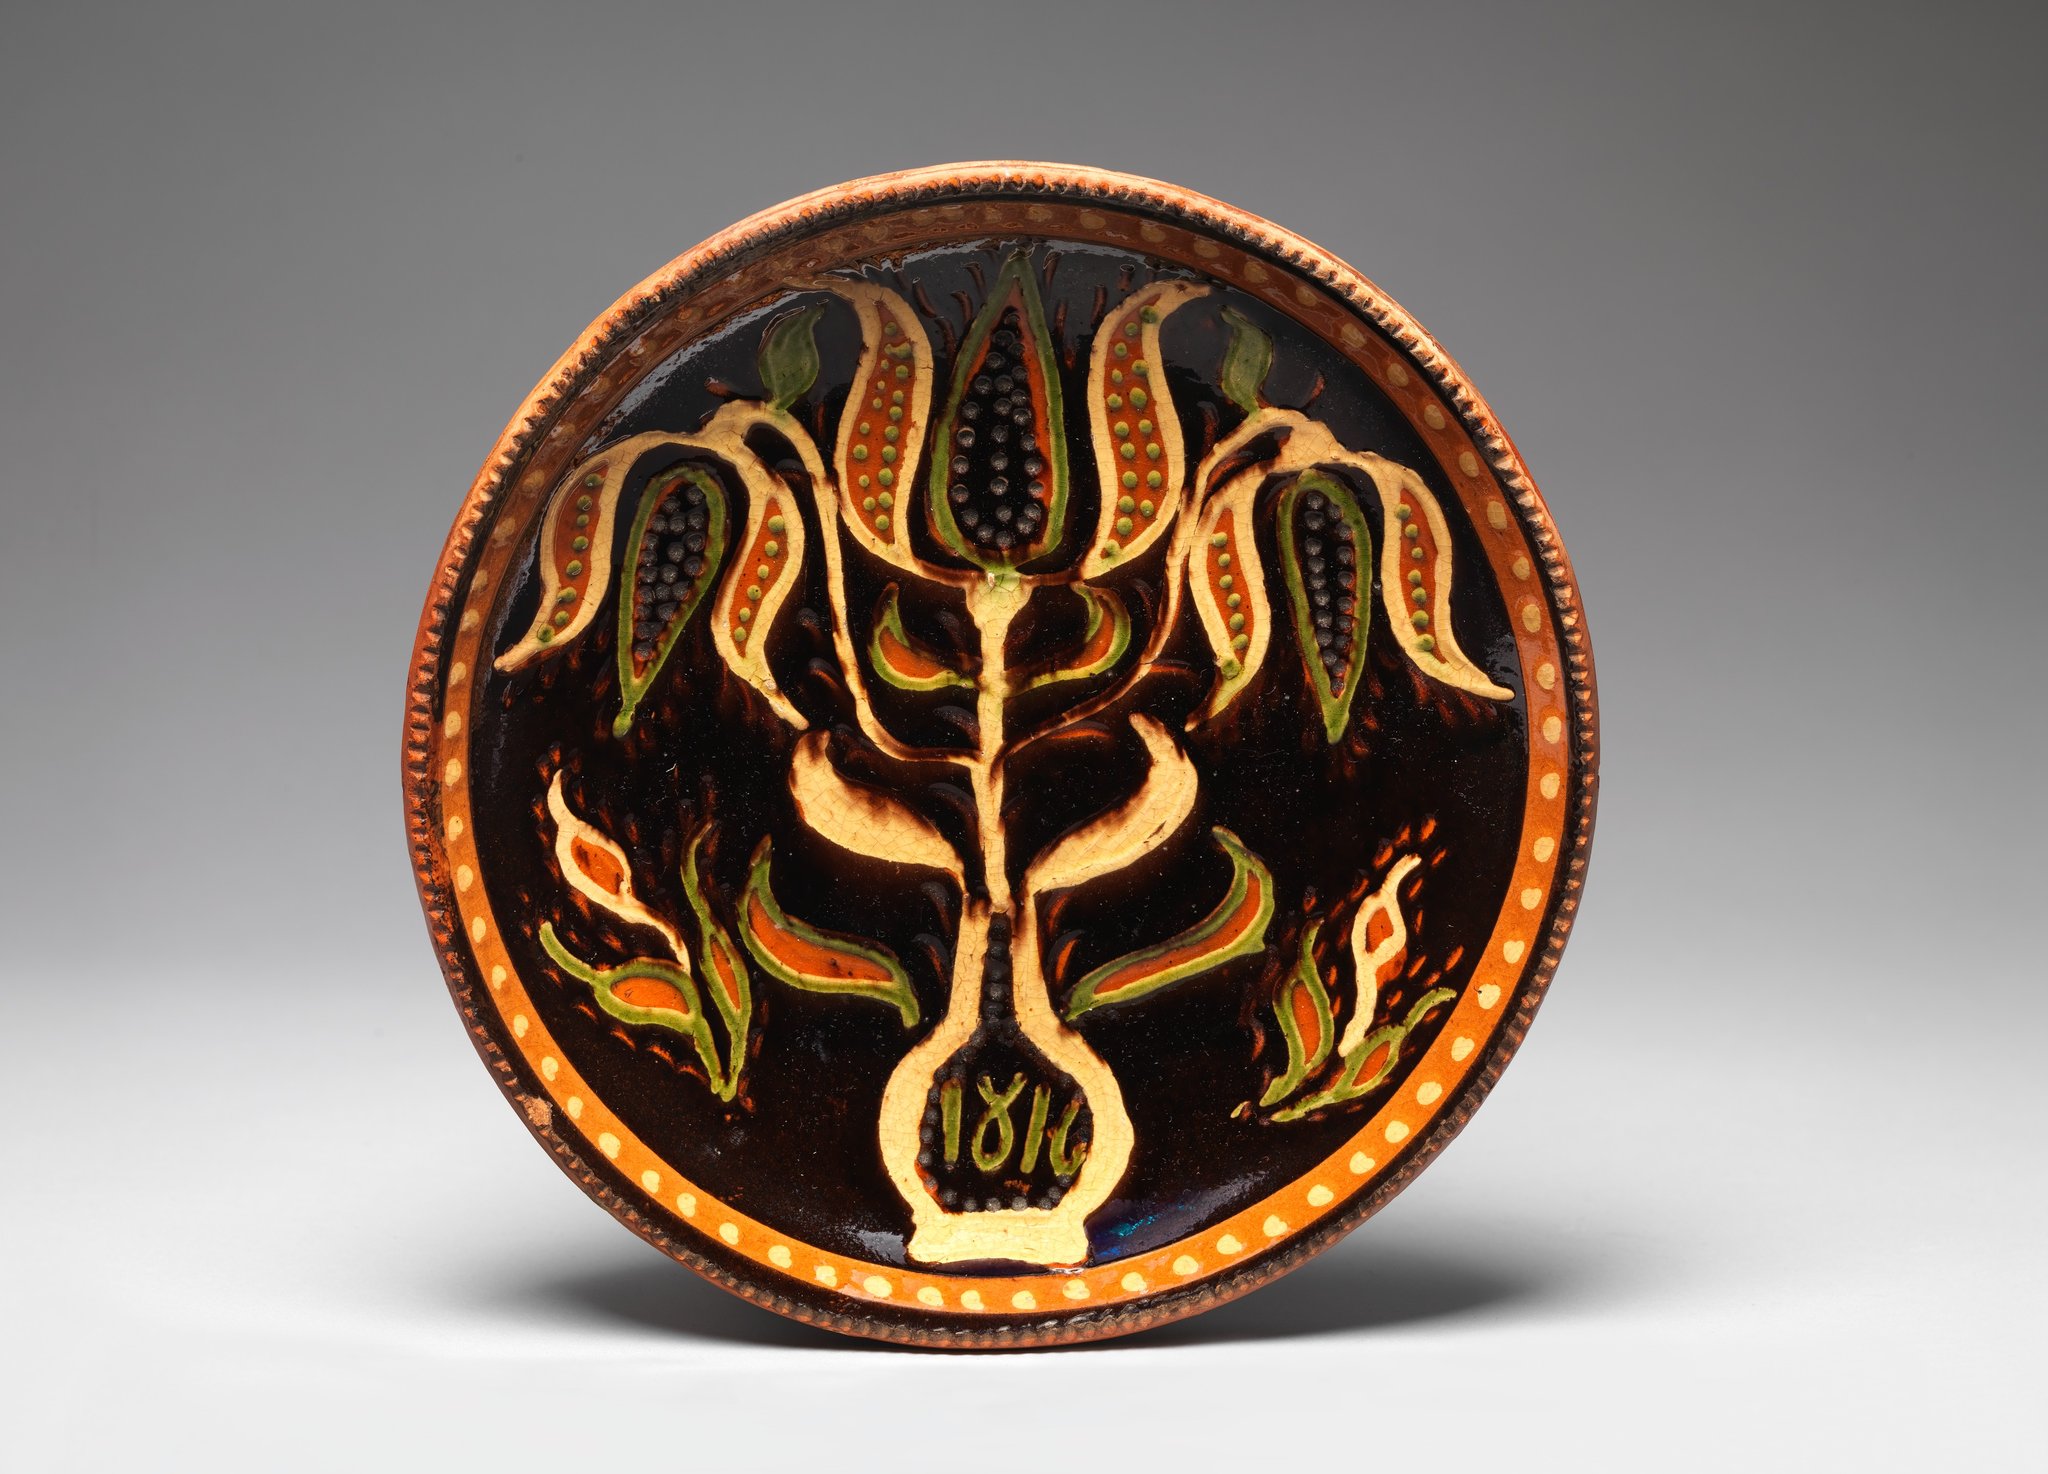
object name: plate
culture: american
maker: solomon grimm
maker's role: maker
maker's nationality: american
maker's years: 1787-1847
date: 1816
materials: earthenware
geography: united states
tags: flowers